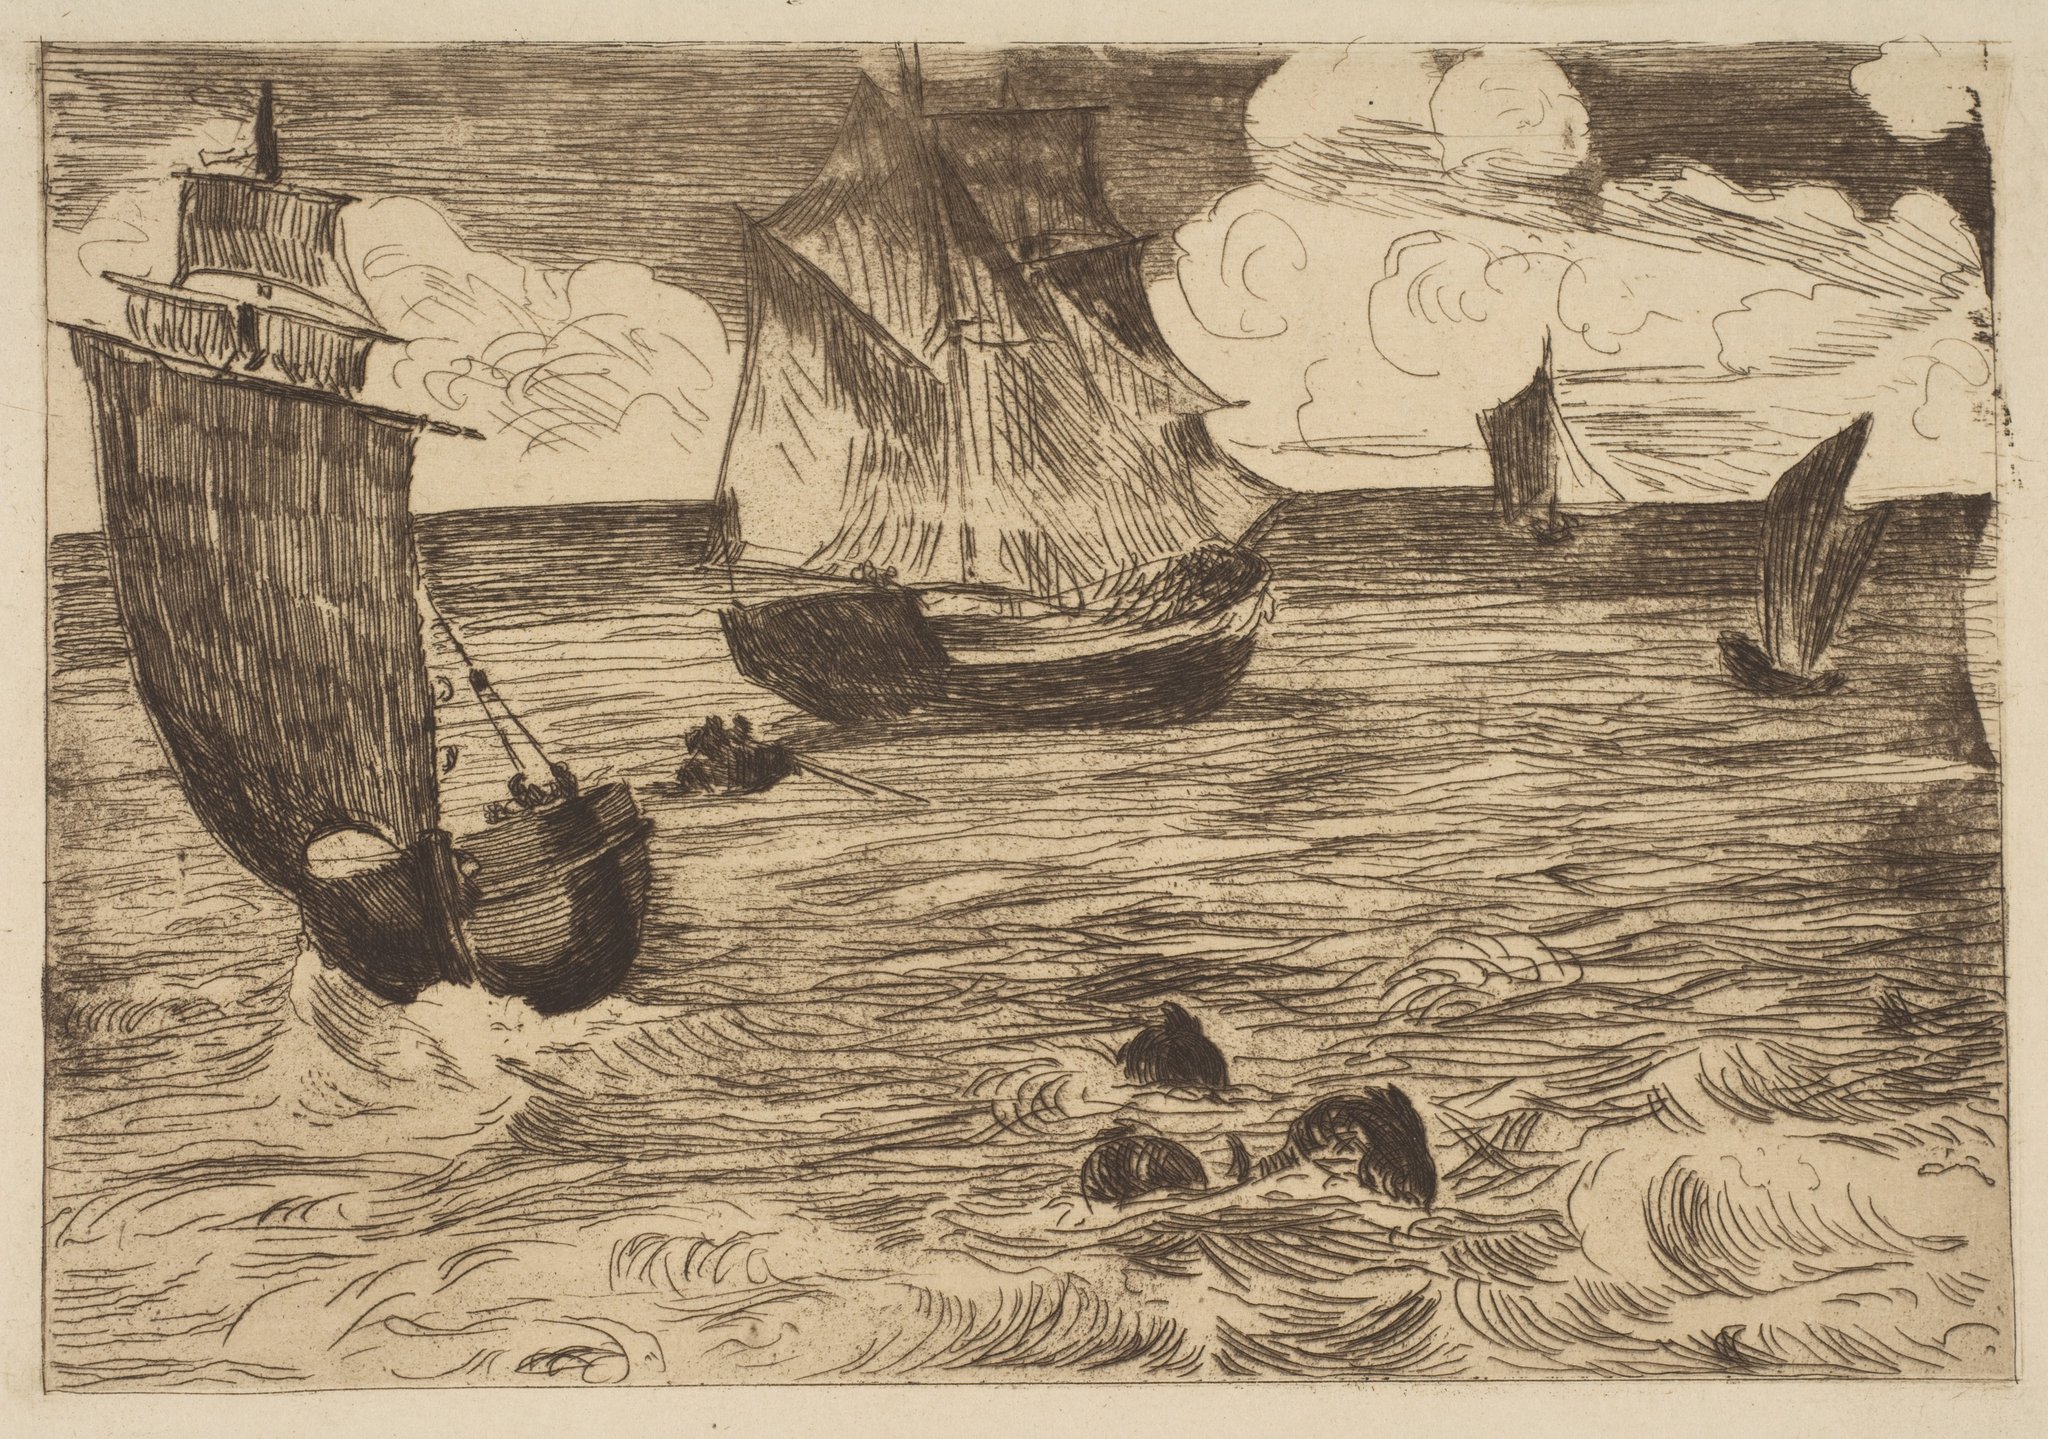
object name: print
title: Marine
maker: édouard manet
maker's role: artist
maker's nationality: french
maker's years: 1832-1883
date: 1865-1866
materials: ink, paper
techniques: aquatint, etching, roulette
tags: waves,ships